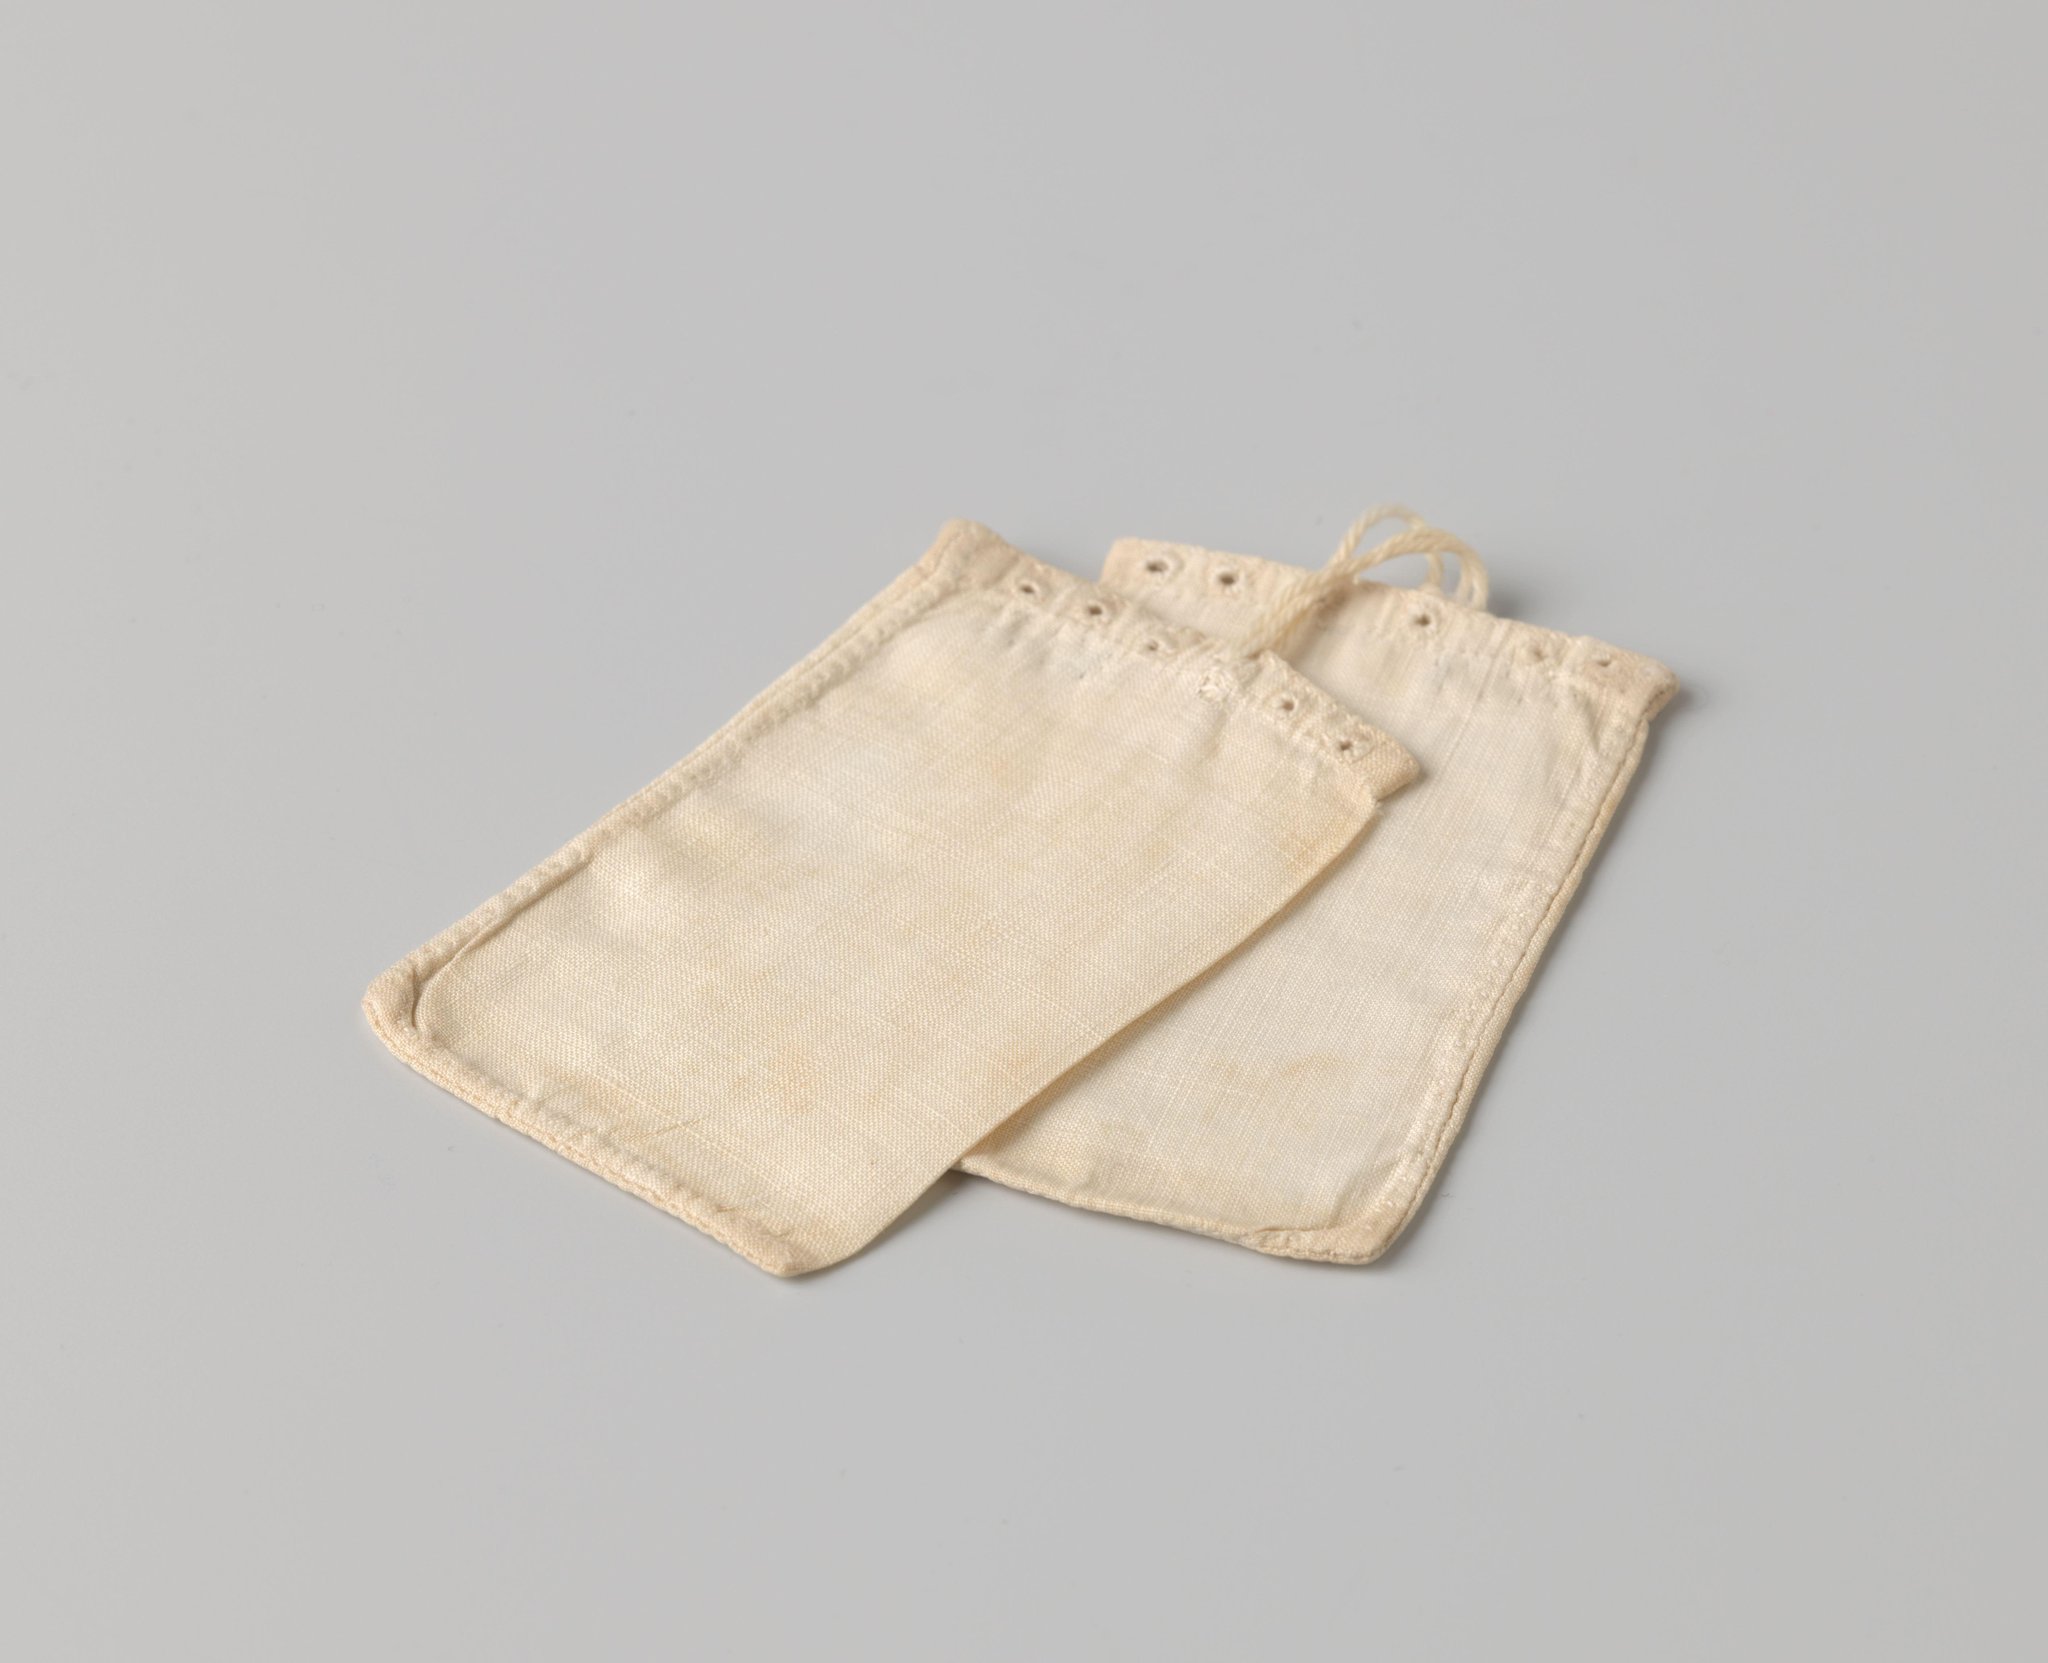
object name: miniature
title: Sloop met koordsluiting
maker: Anonymous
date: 1750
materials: linen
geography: netherlands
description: Sloop voor kussen, aan korte zijde voorzien van zes gaten voor koordsluiting.